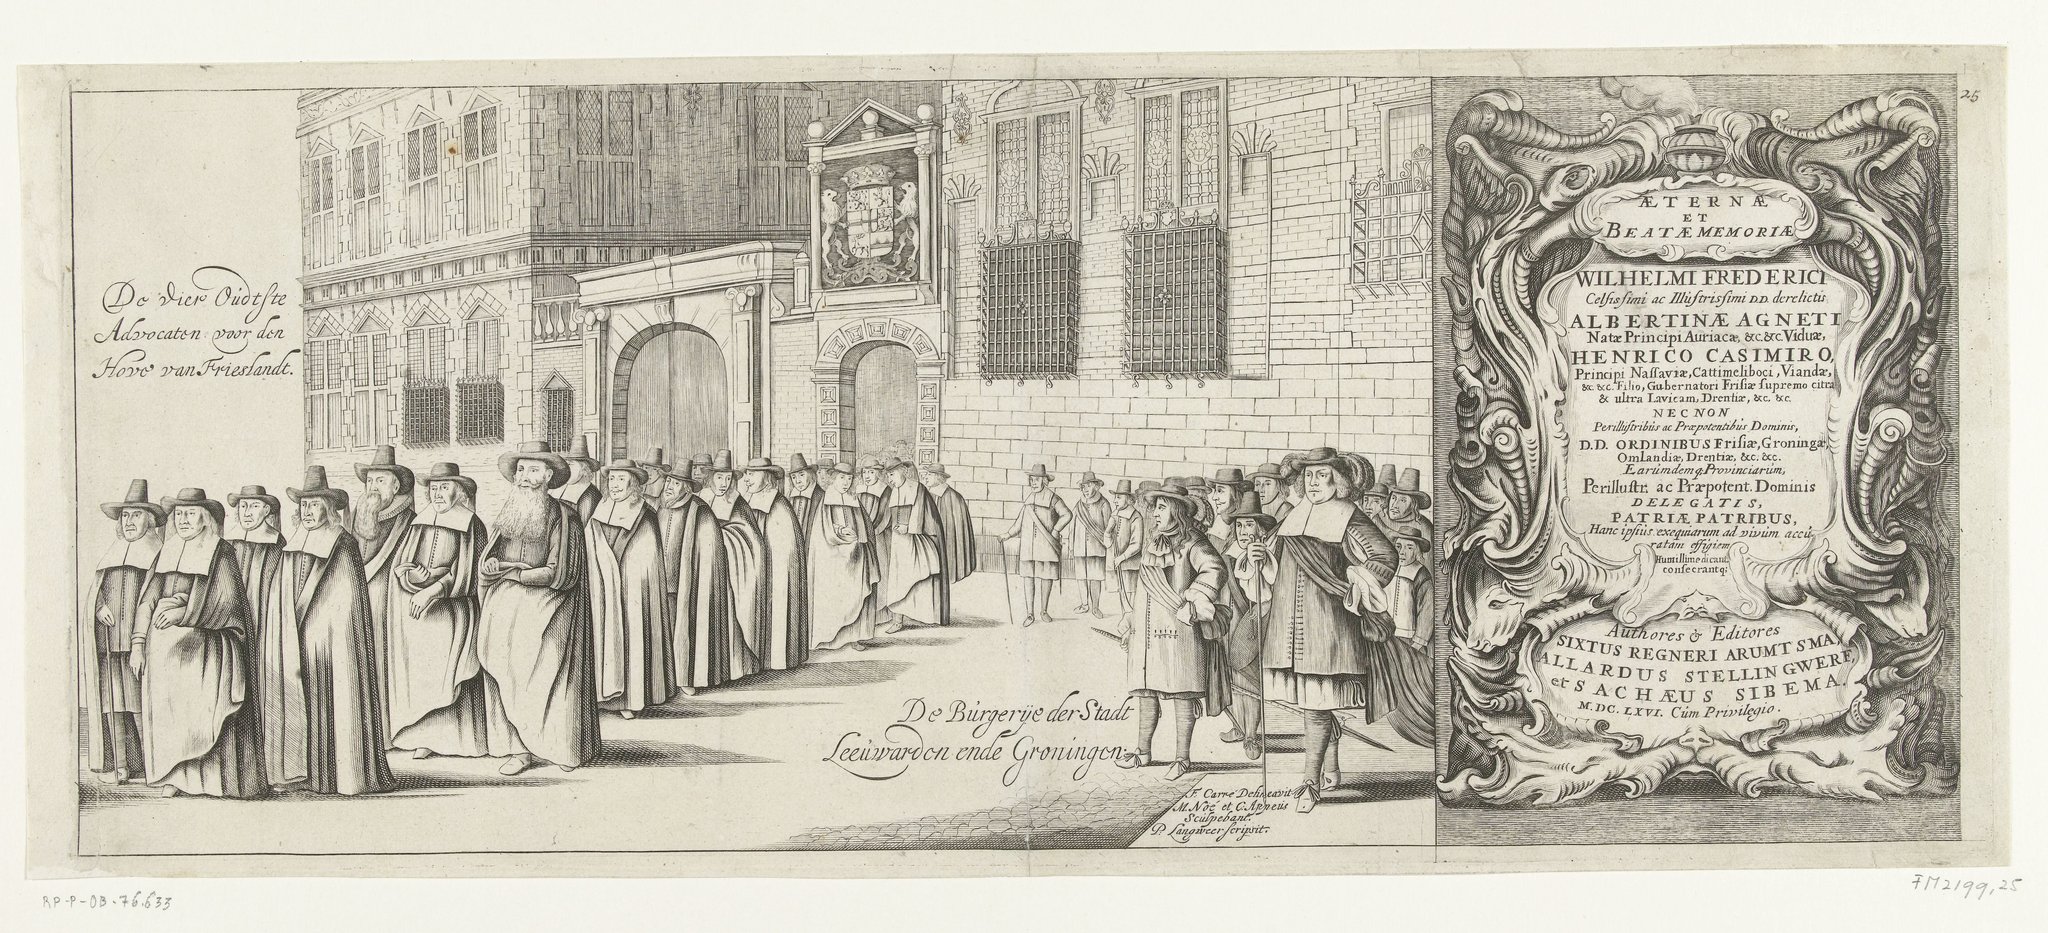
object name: print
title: Begrafenisoptocht van Willem Frederik, graaf van Nassau-Dietz (blad 25), 1665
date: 1666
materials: paper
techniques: engraving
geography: leeuwarden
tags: arnhem, cortege, funeral procession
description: Begrafenisoptocht van Willem Frederik, graaf van Nassau-Dietz, in Leeuwarden op 6 januari 1665. Het begin van de begrafenisstoet bij het Hof van Friesland. Rechts een cartouche met tekst in het Latijn. Plaat nr. 25 in een ensemble van 25 ongemonteerde genummerde platen en twee tekstbladen die samen een lange fries vormen.